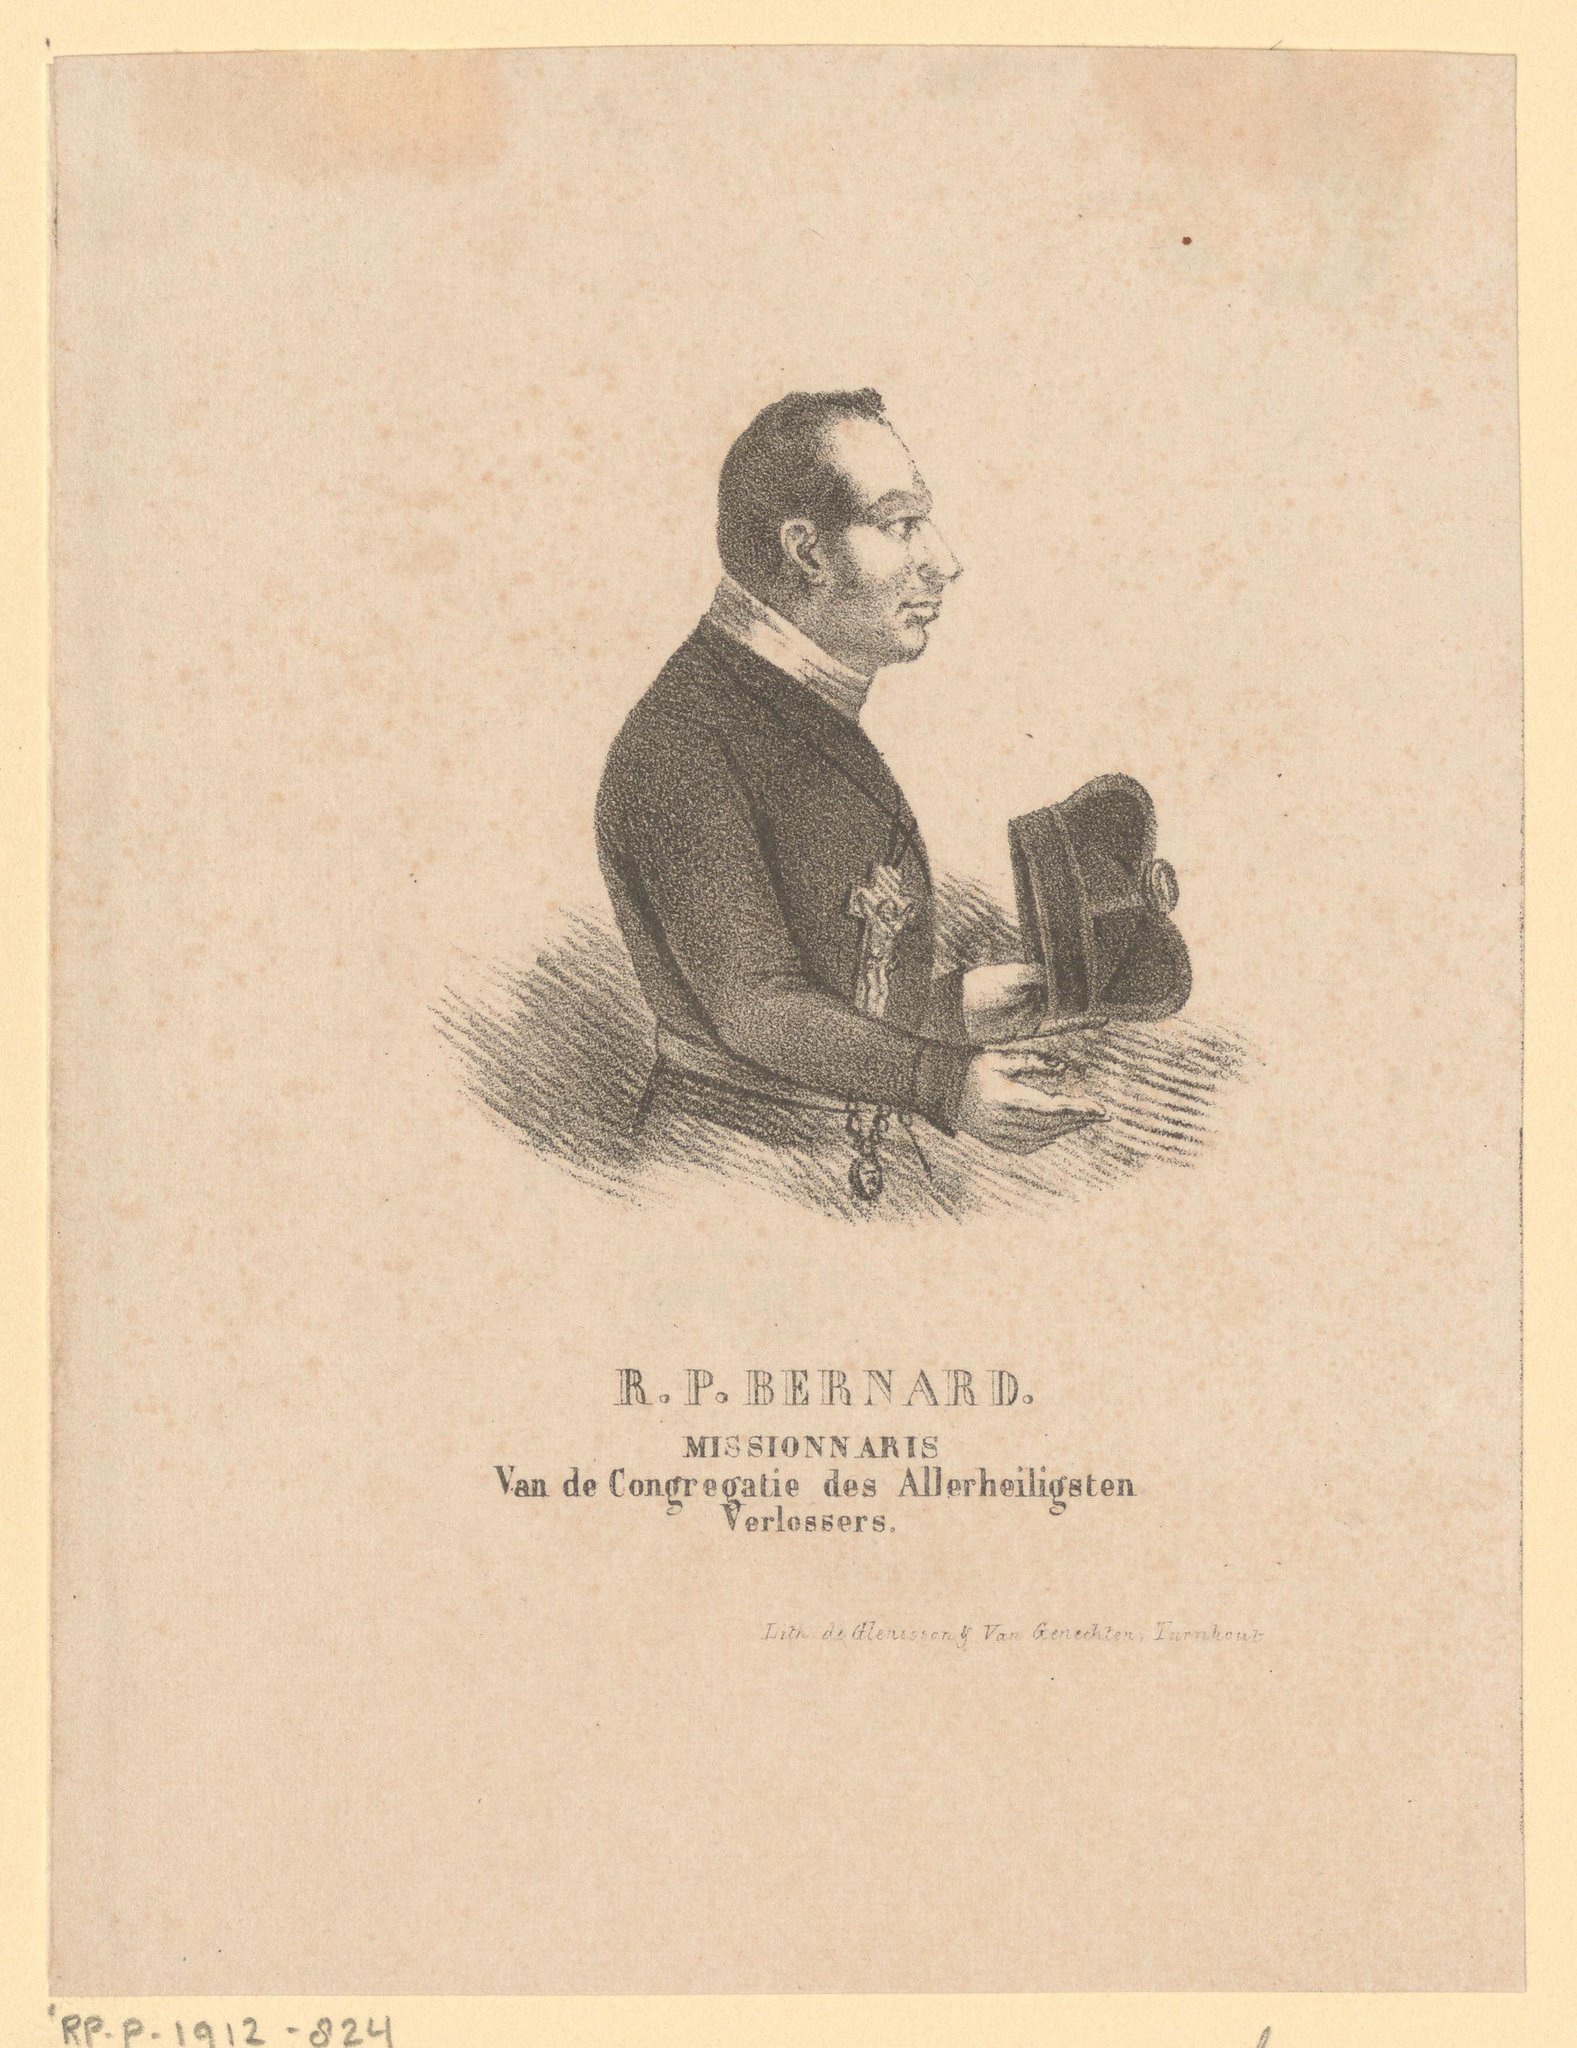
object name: print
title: Portret van Bernard Hafkenscheid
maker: Anonymous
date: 1833-1856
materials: paper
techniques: lithograph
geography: turnhout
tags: historical persons, crucifix ~ personal devotion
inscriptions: collector's mark: Lugt 2228